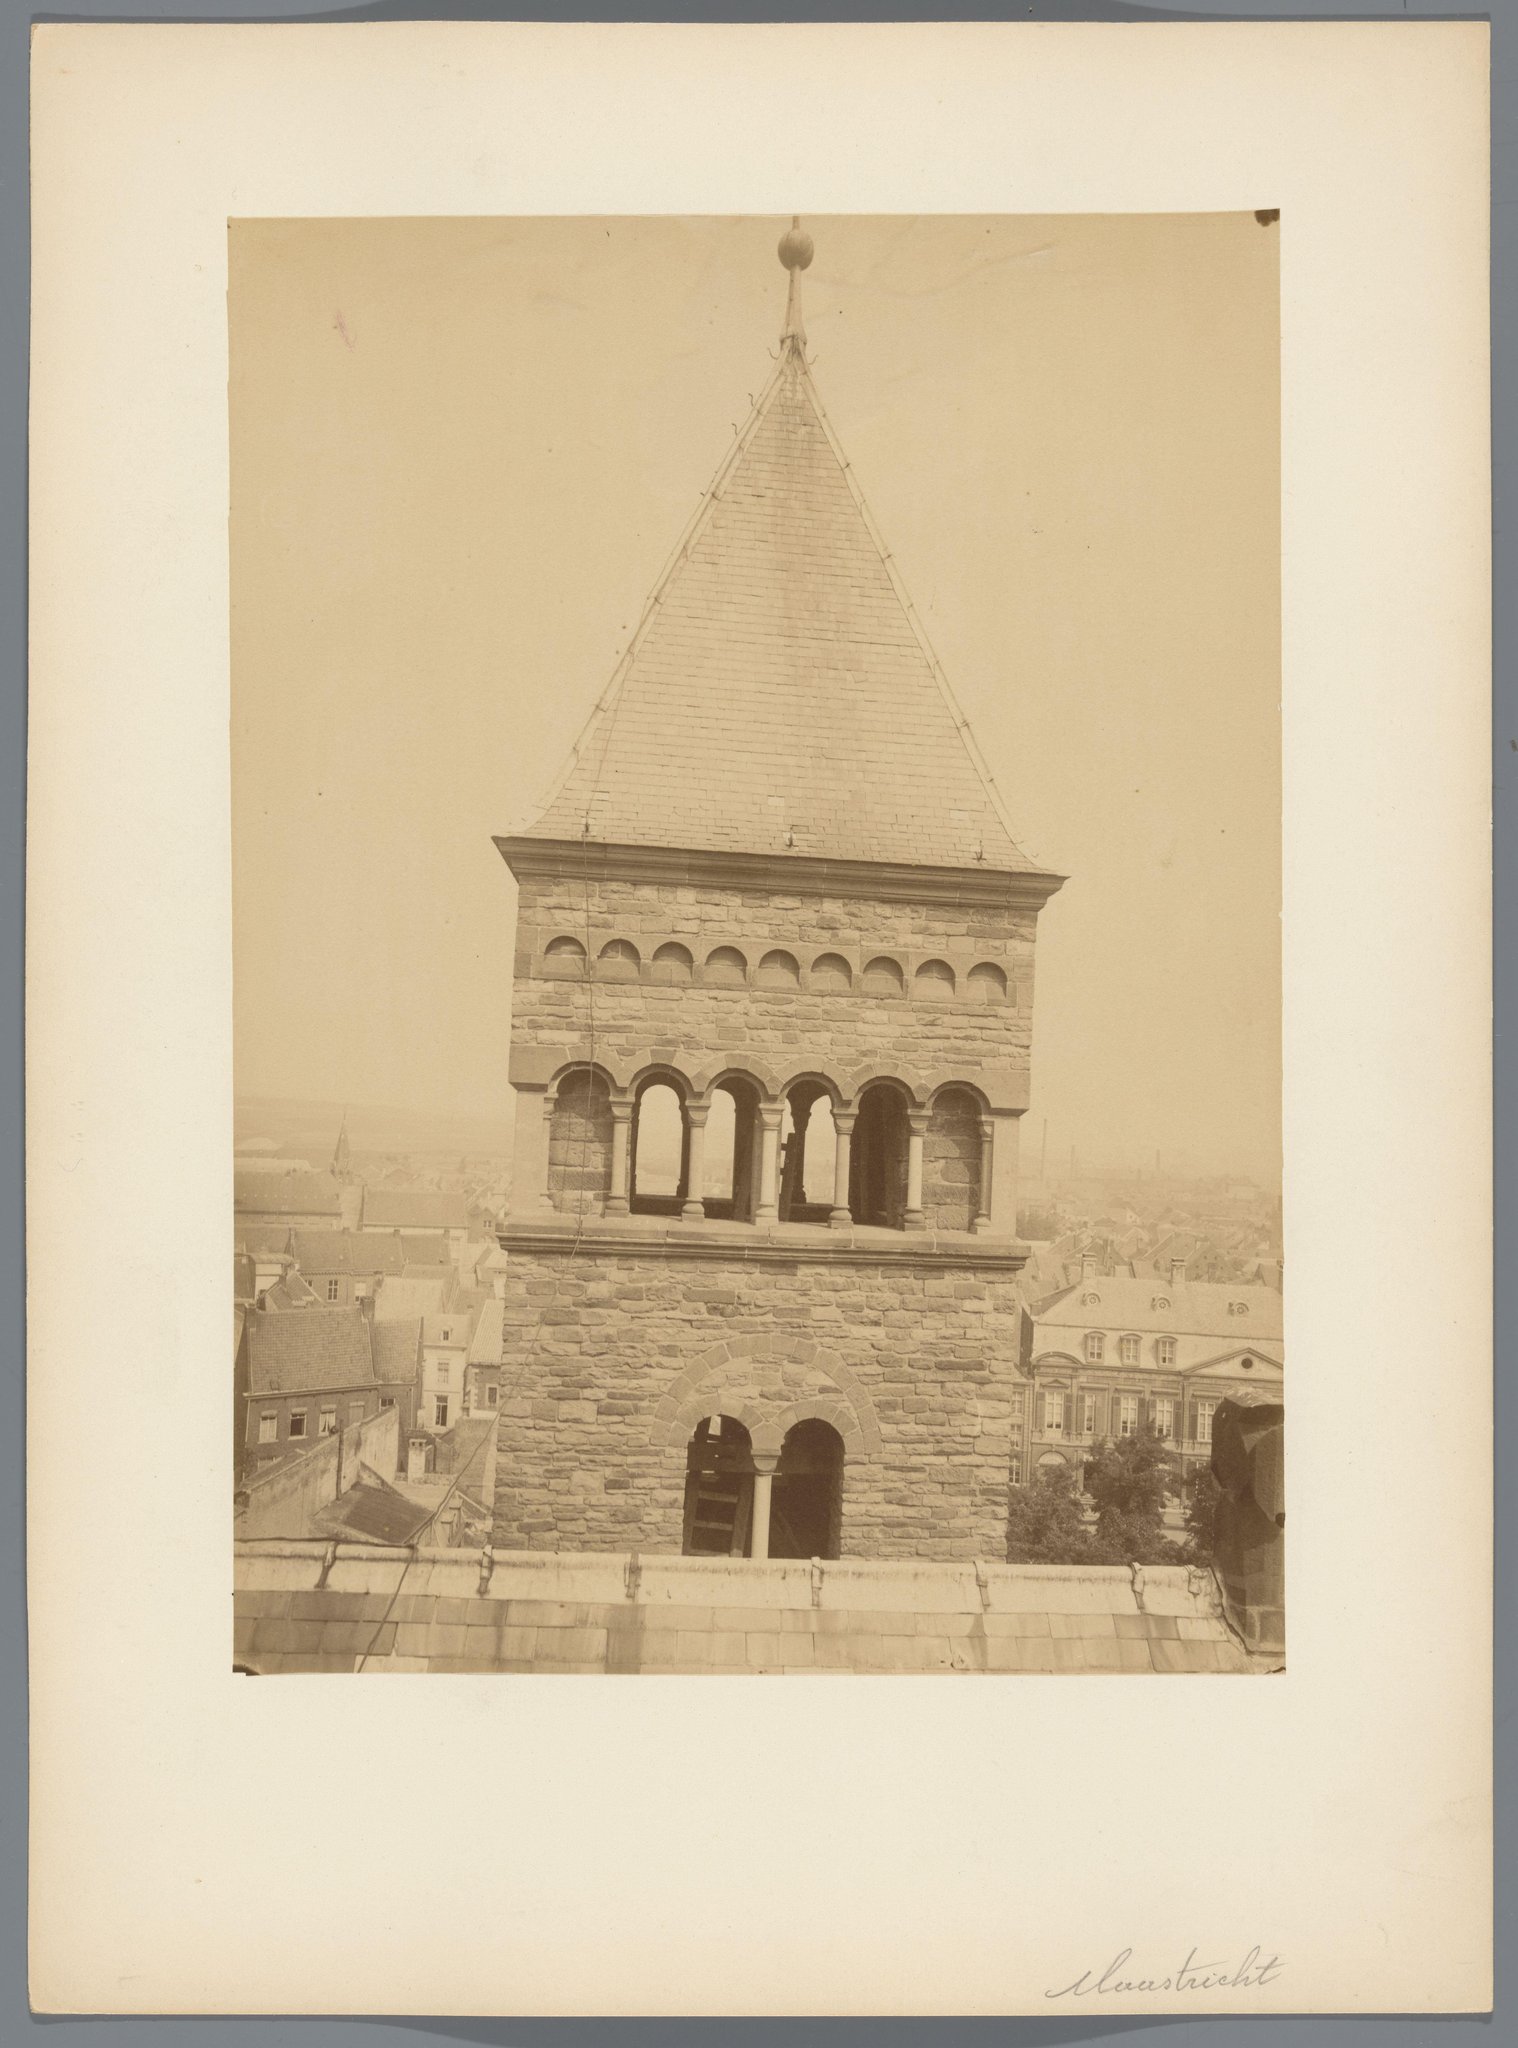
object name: photograph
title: Bovengedeelte van de noordelijke toren van de Sint-Servaasbasiliek te Maastricht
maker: anoniem (monumentenzorg)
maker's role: fotograaf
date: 1893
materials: cardboard, photographic support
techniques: albumen print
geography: maastricht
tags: parts of church exterior and annexes: tower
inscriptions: annotation: ‘St. Servaaskerk Maastricht/ Bovengedeelte van den noordelijke toren naast het koor/ Mei 1893’, annotation: ‘Maastricht’